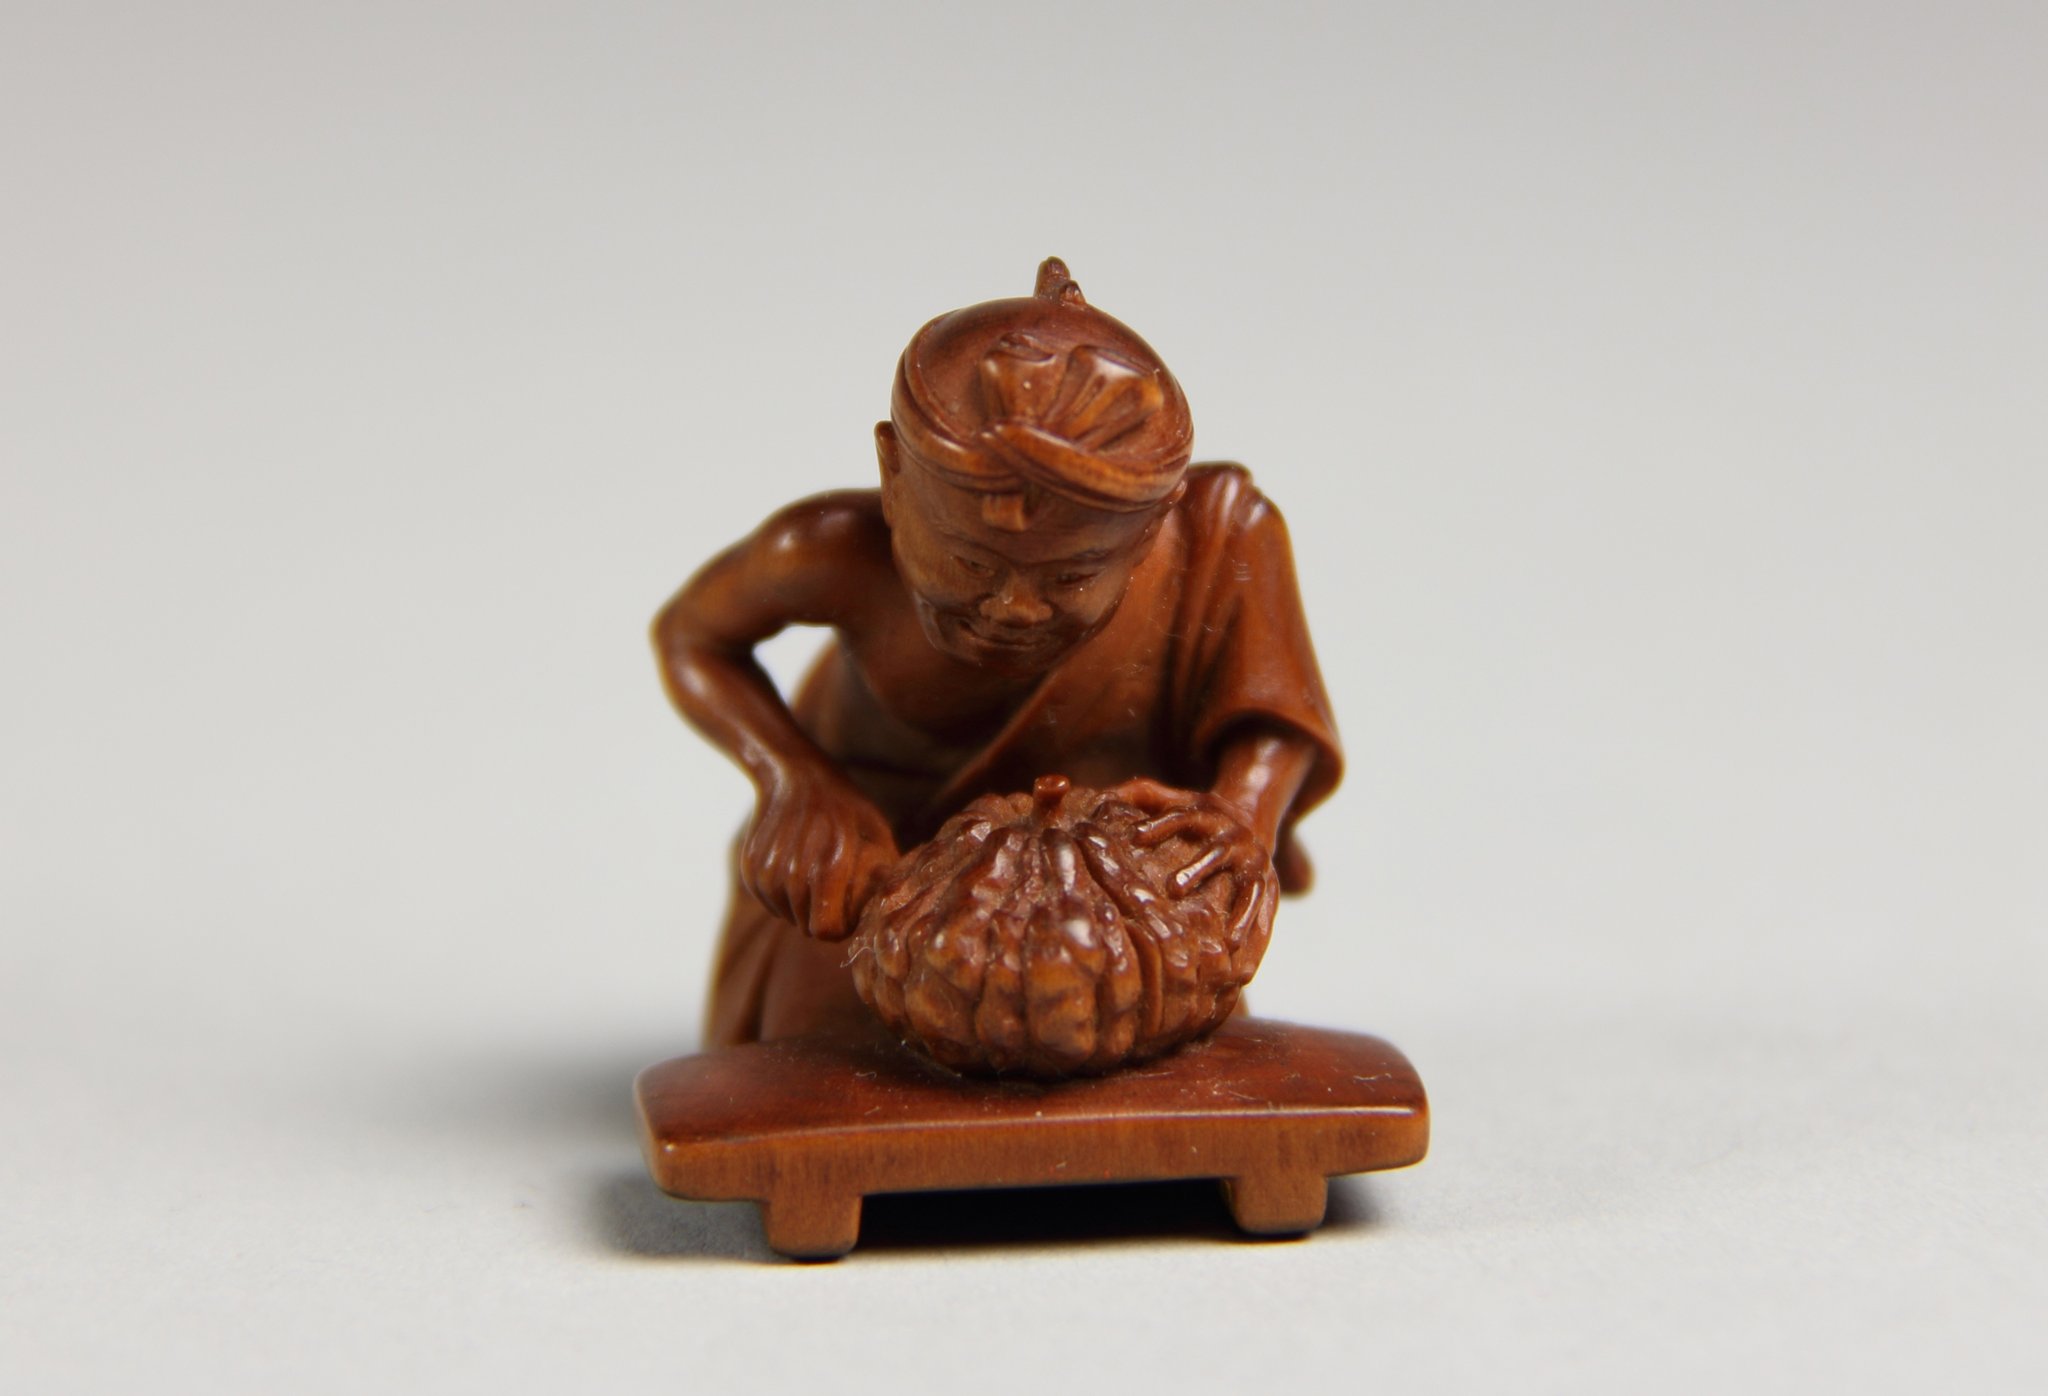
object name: netsuke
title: Netsuke of Man Cutting Pumpkin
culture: japanese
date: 1867-1900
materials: wood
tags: vegetables,men